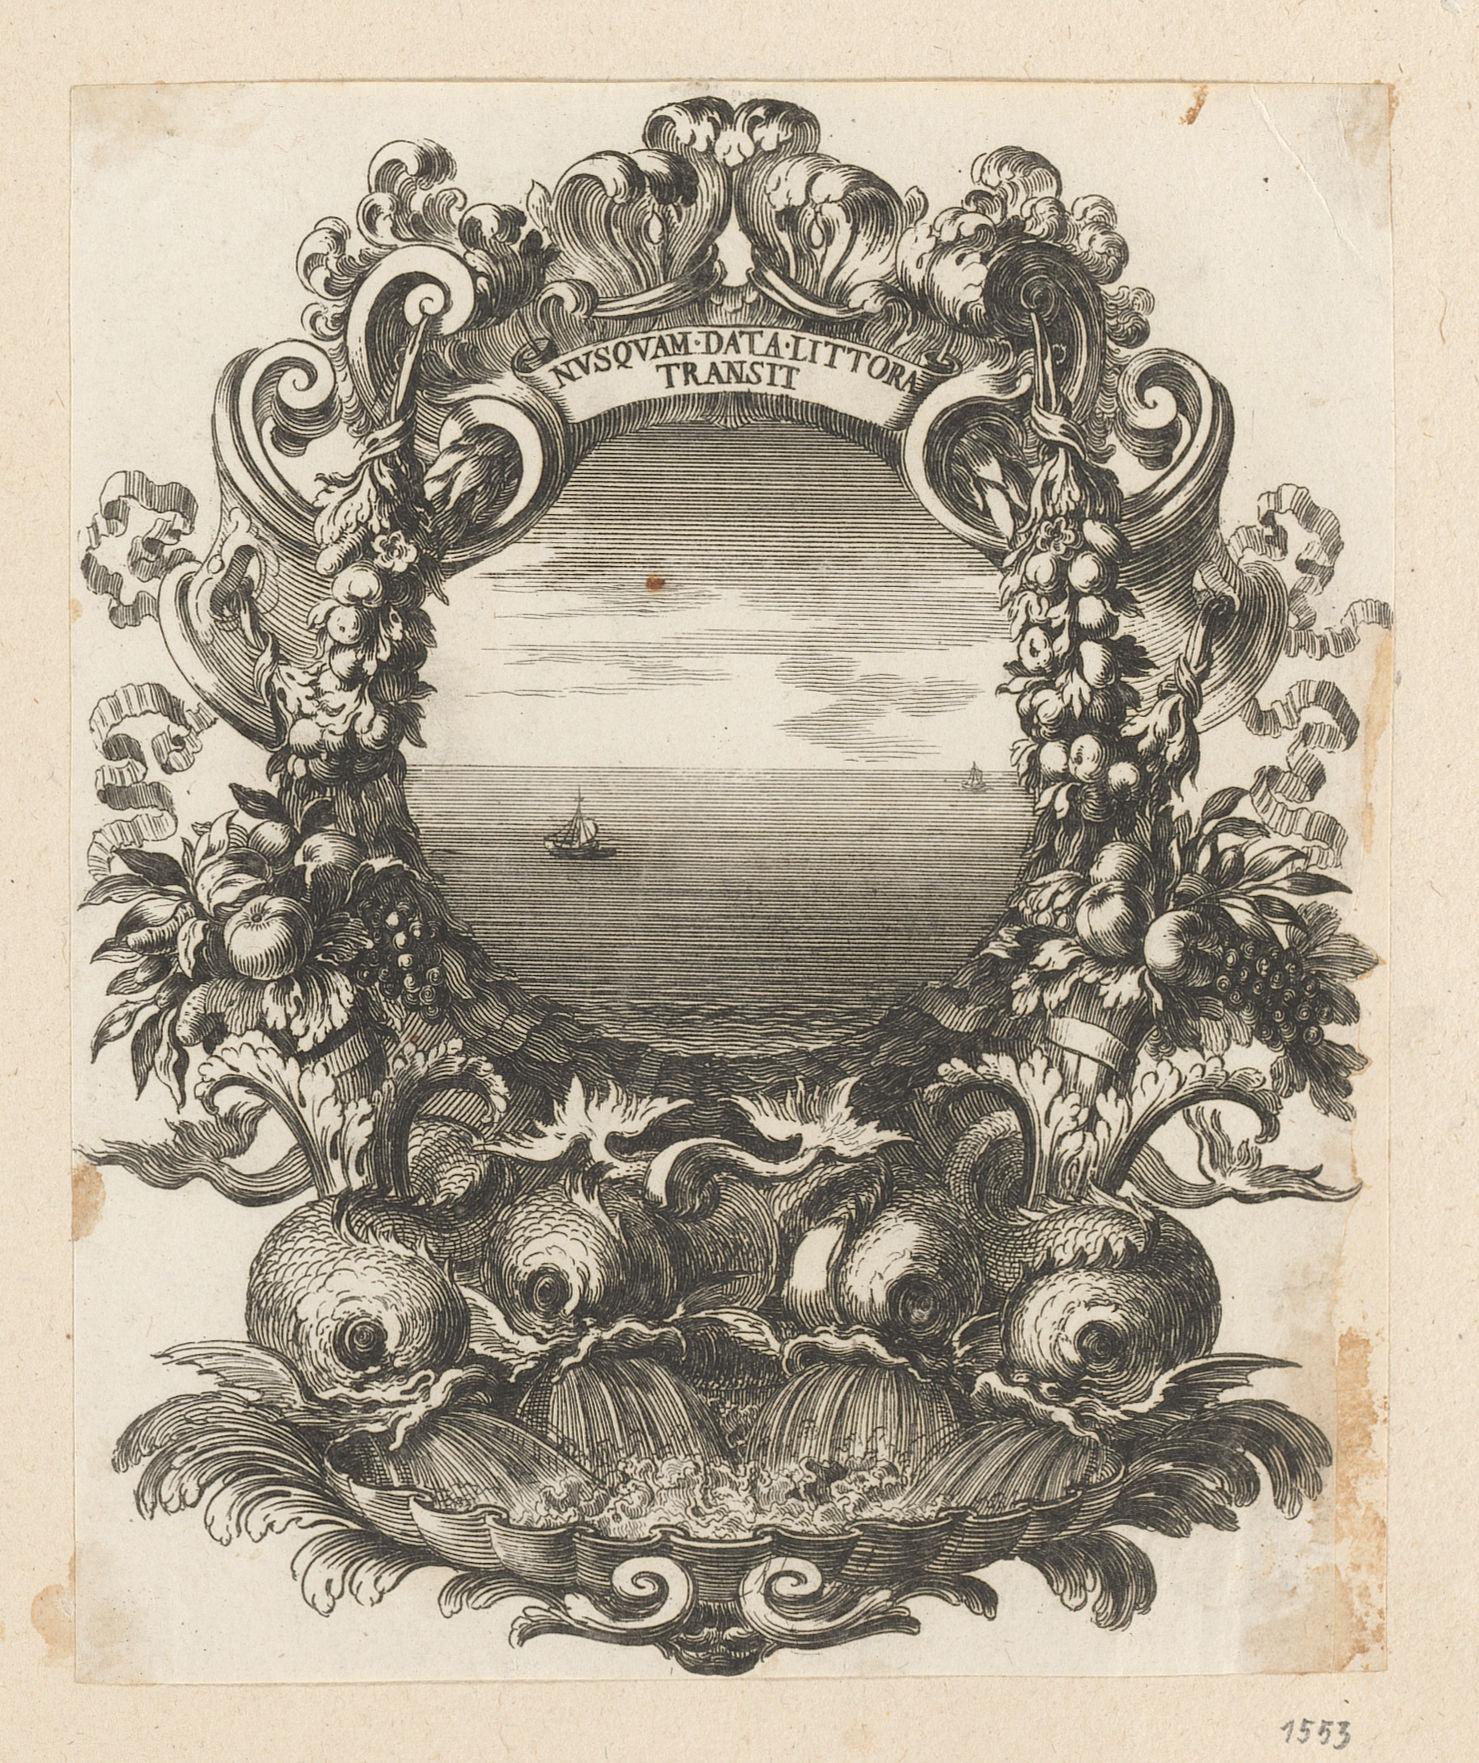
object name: book illustration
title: Zeegezicht in een cartouche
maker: sébastien leclerc (i)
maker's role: print maker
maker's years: 1637-1714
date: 1670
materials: paper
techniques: etching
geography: paris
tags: dolphin ~ ornament, sea (seascape)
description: Prent gebruikt voor: Félibien, André. Devises pour les tapisseries du Roy, où sont représentez les quatre éléments et les quatre saisons de l'année (...). Parijs: Imprimerie Royale, 1670.